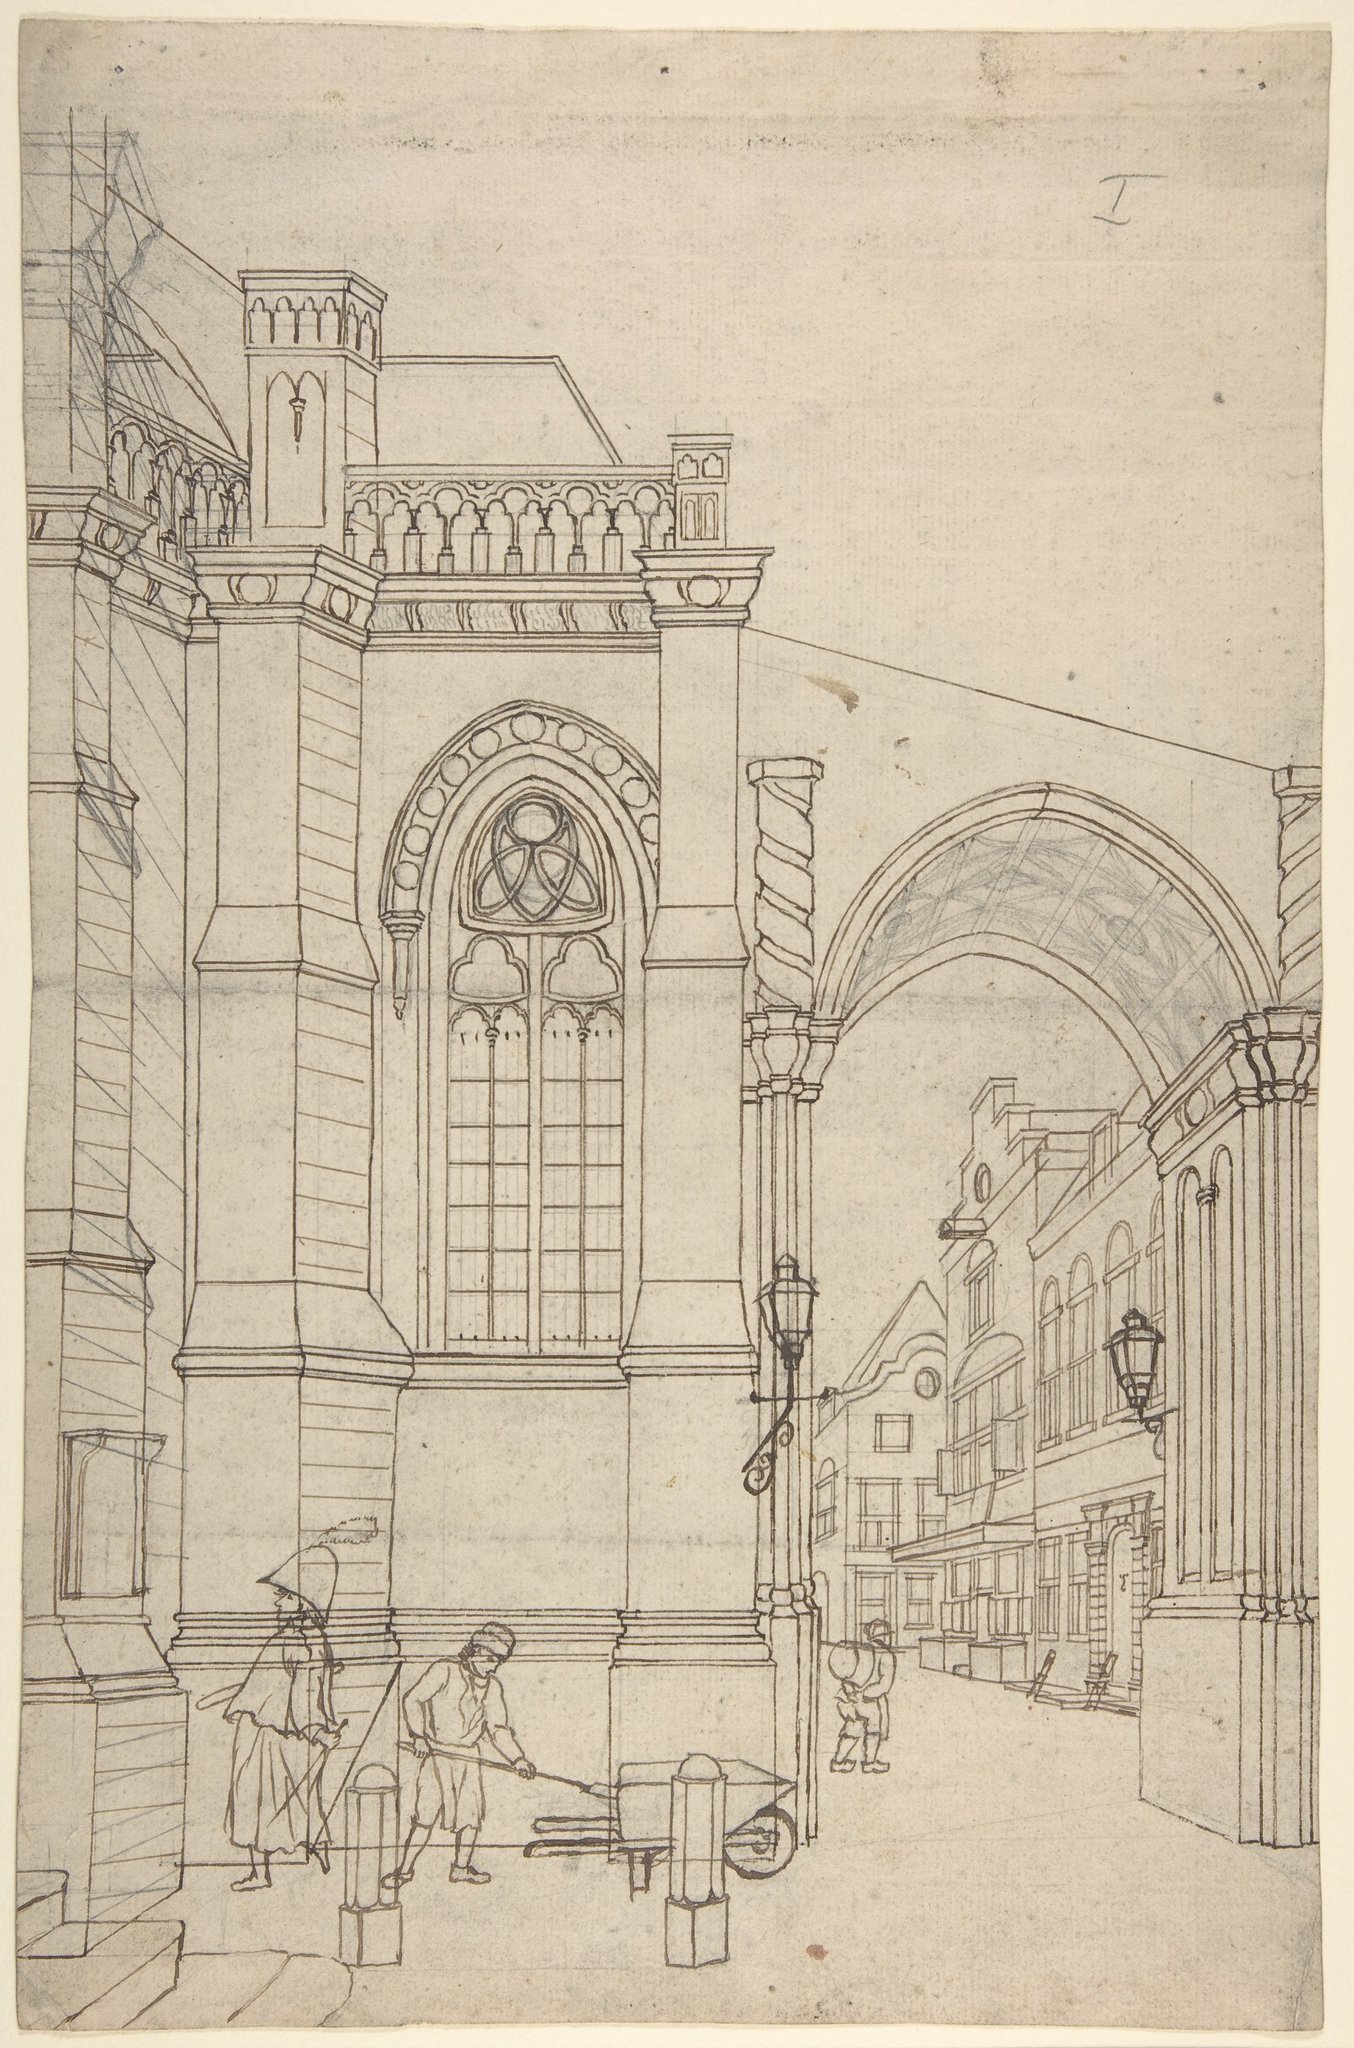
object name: drawing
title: A Townscape with a Churchgate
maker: jan hendrik verheyen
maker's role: artist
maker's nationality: dutch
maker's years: 1778-1846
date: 1801-1833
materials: graphite, ink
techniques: pen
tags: human figures,buildings,gates,churches,towns